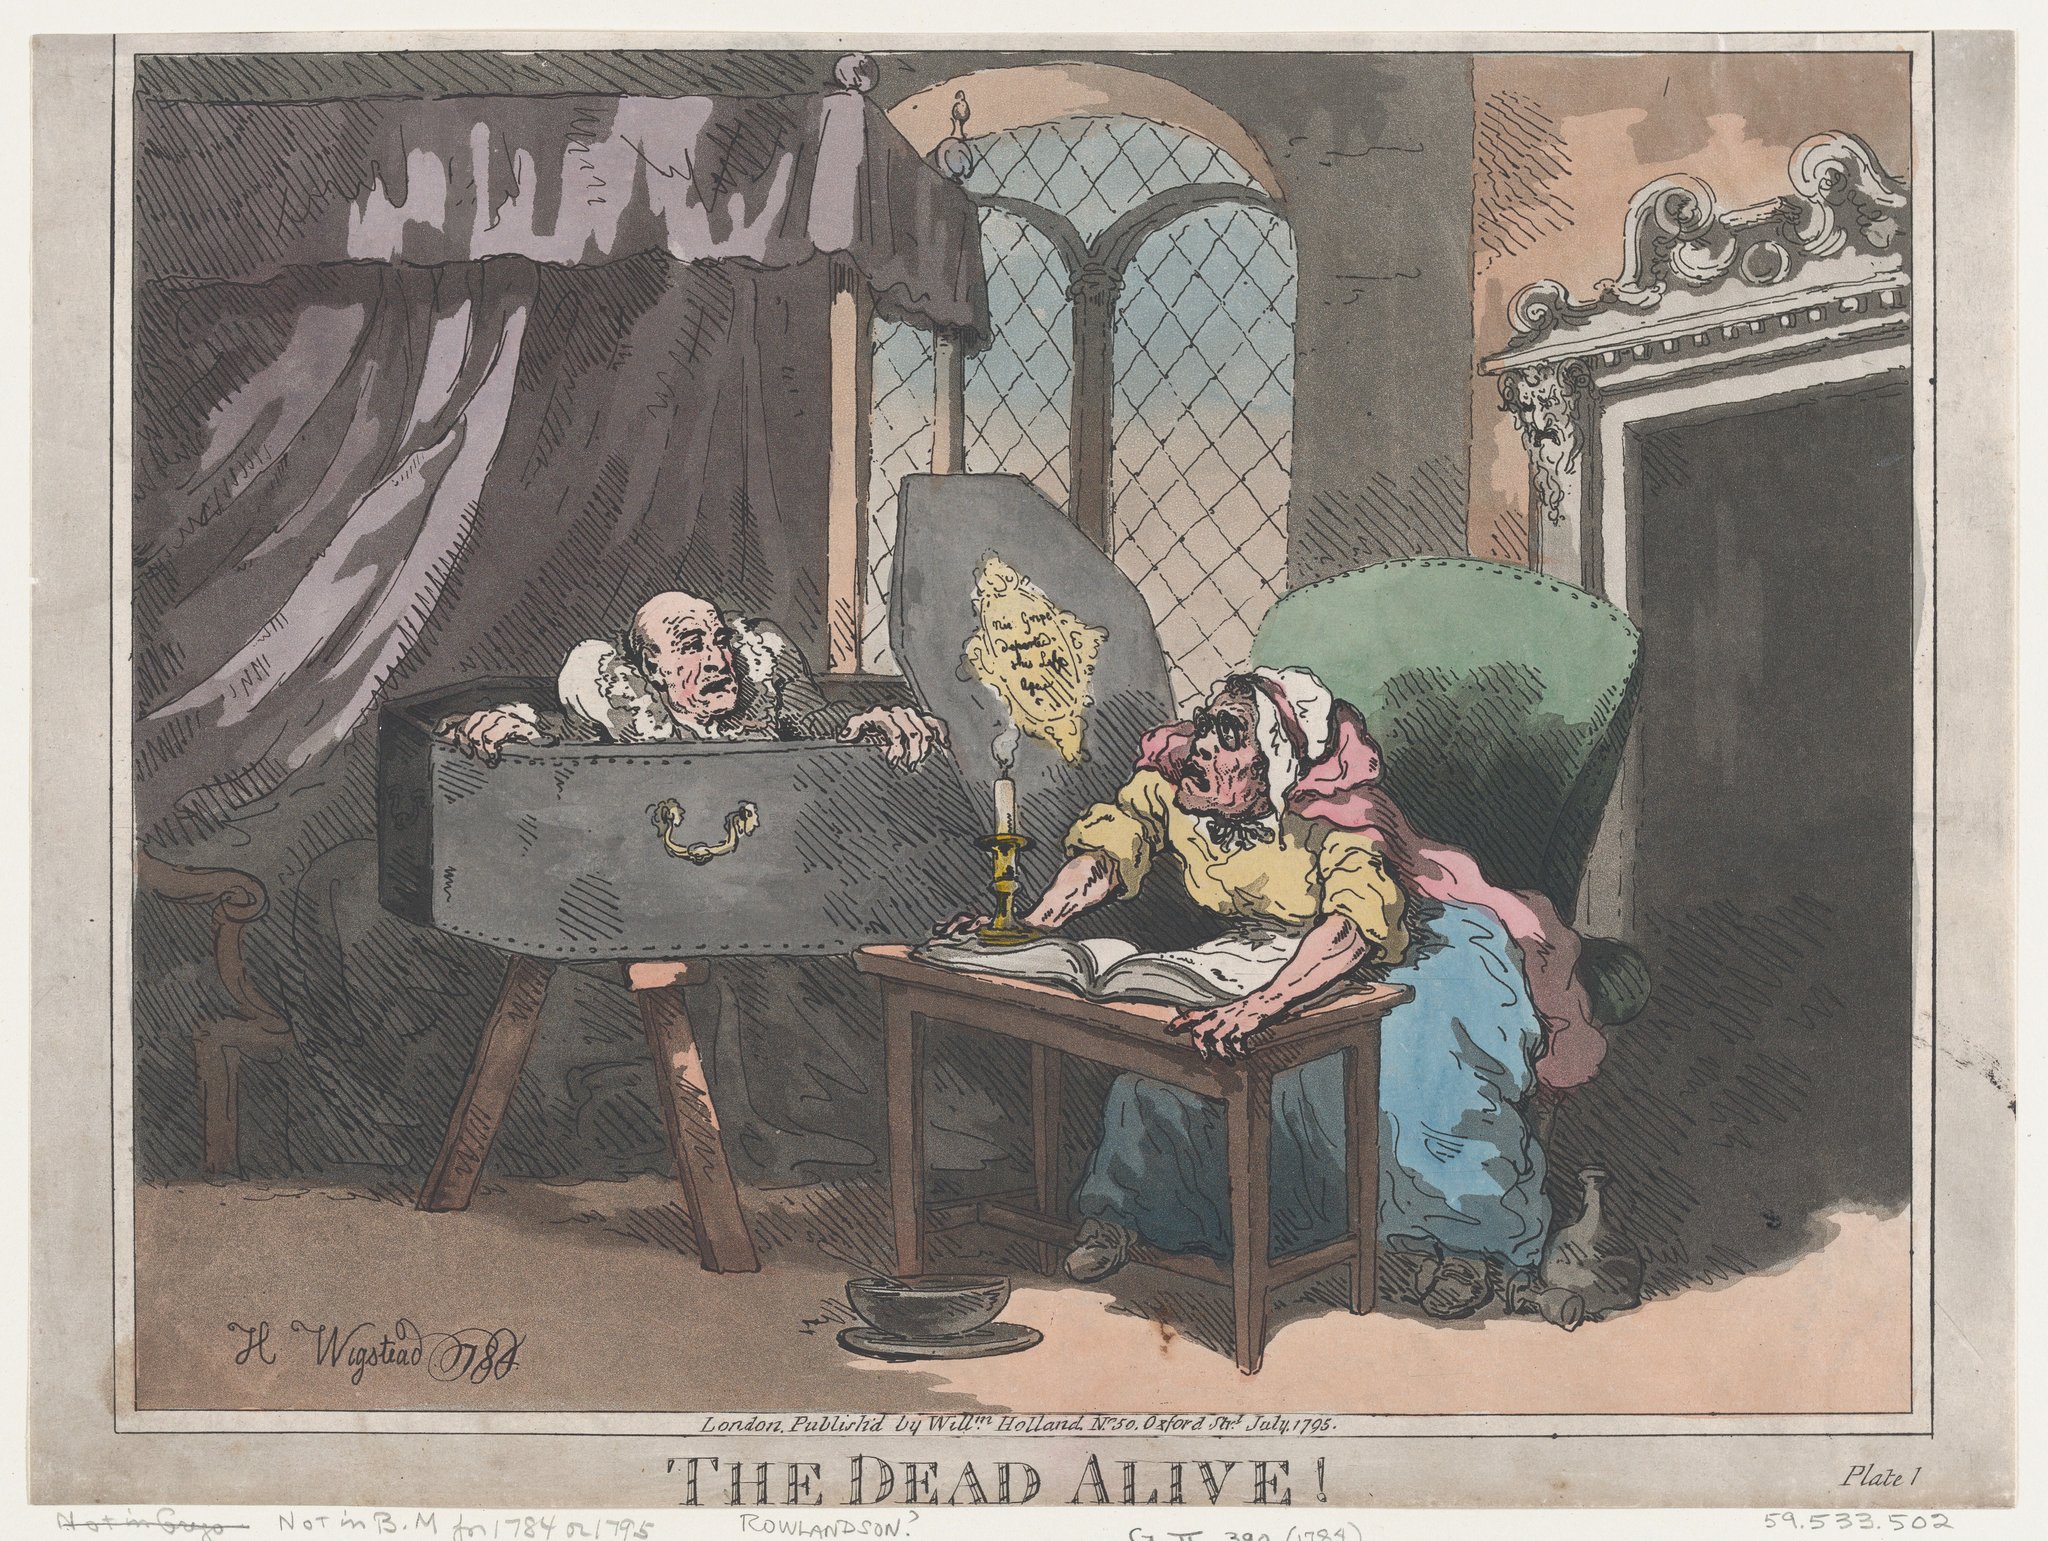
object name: print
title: The Dead Alive!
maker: thomas rowlandson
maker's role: artist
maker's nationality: british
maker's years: 1757-1827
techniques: etching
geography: london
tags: satire,bedrooms,men,women